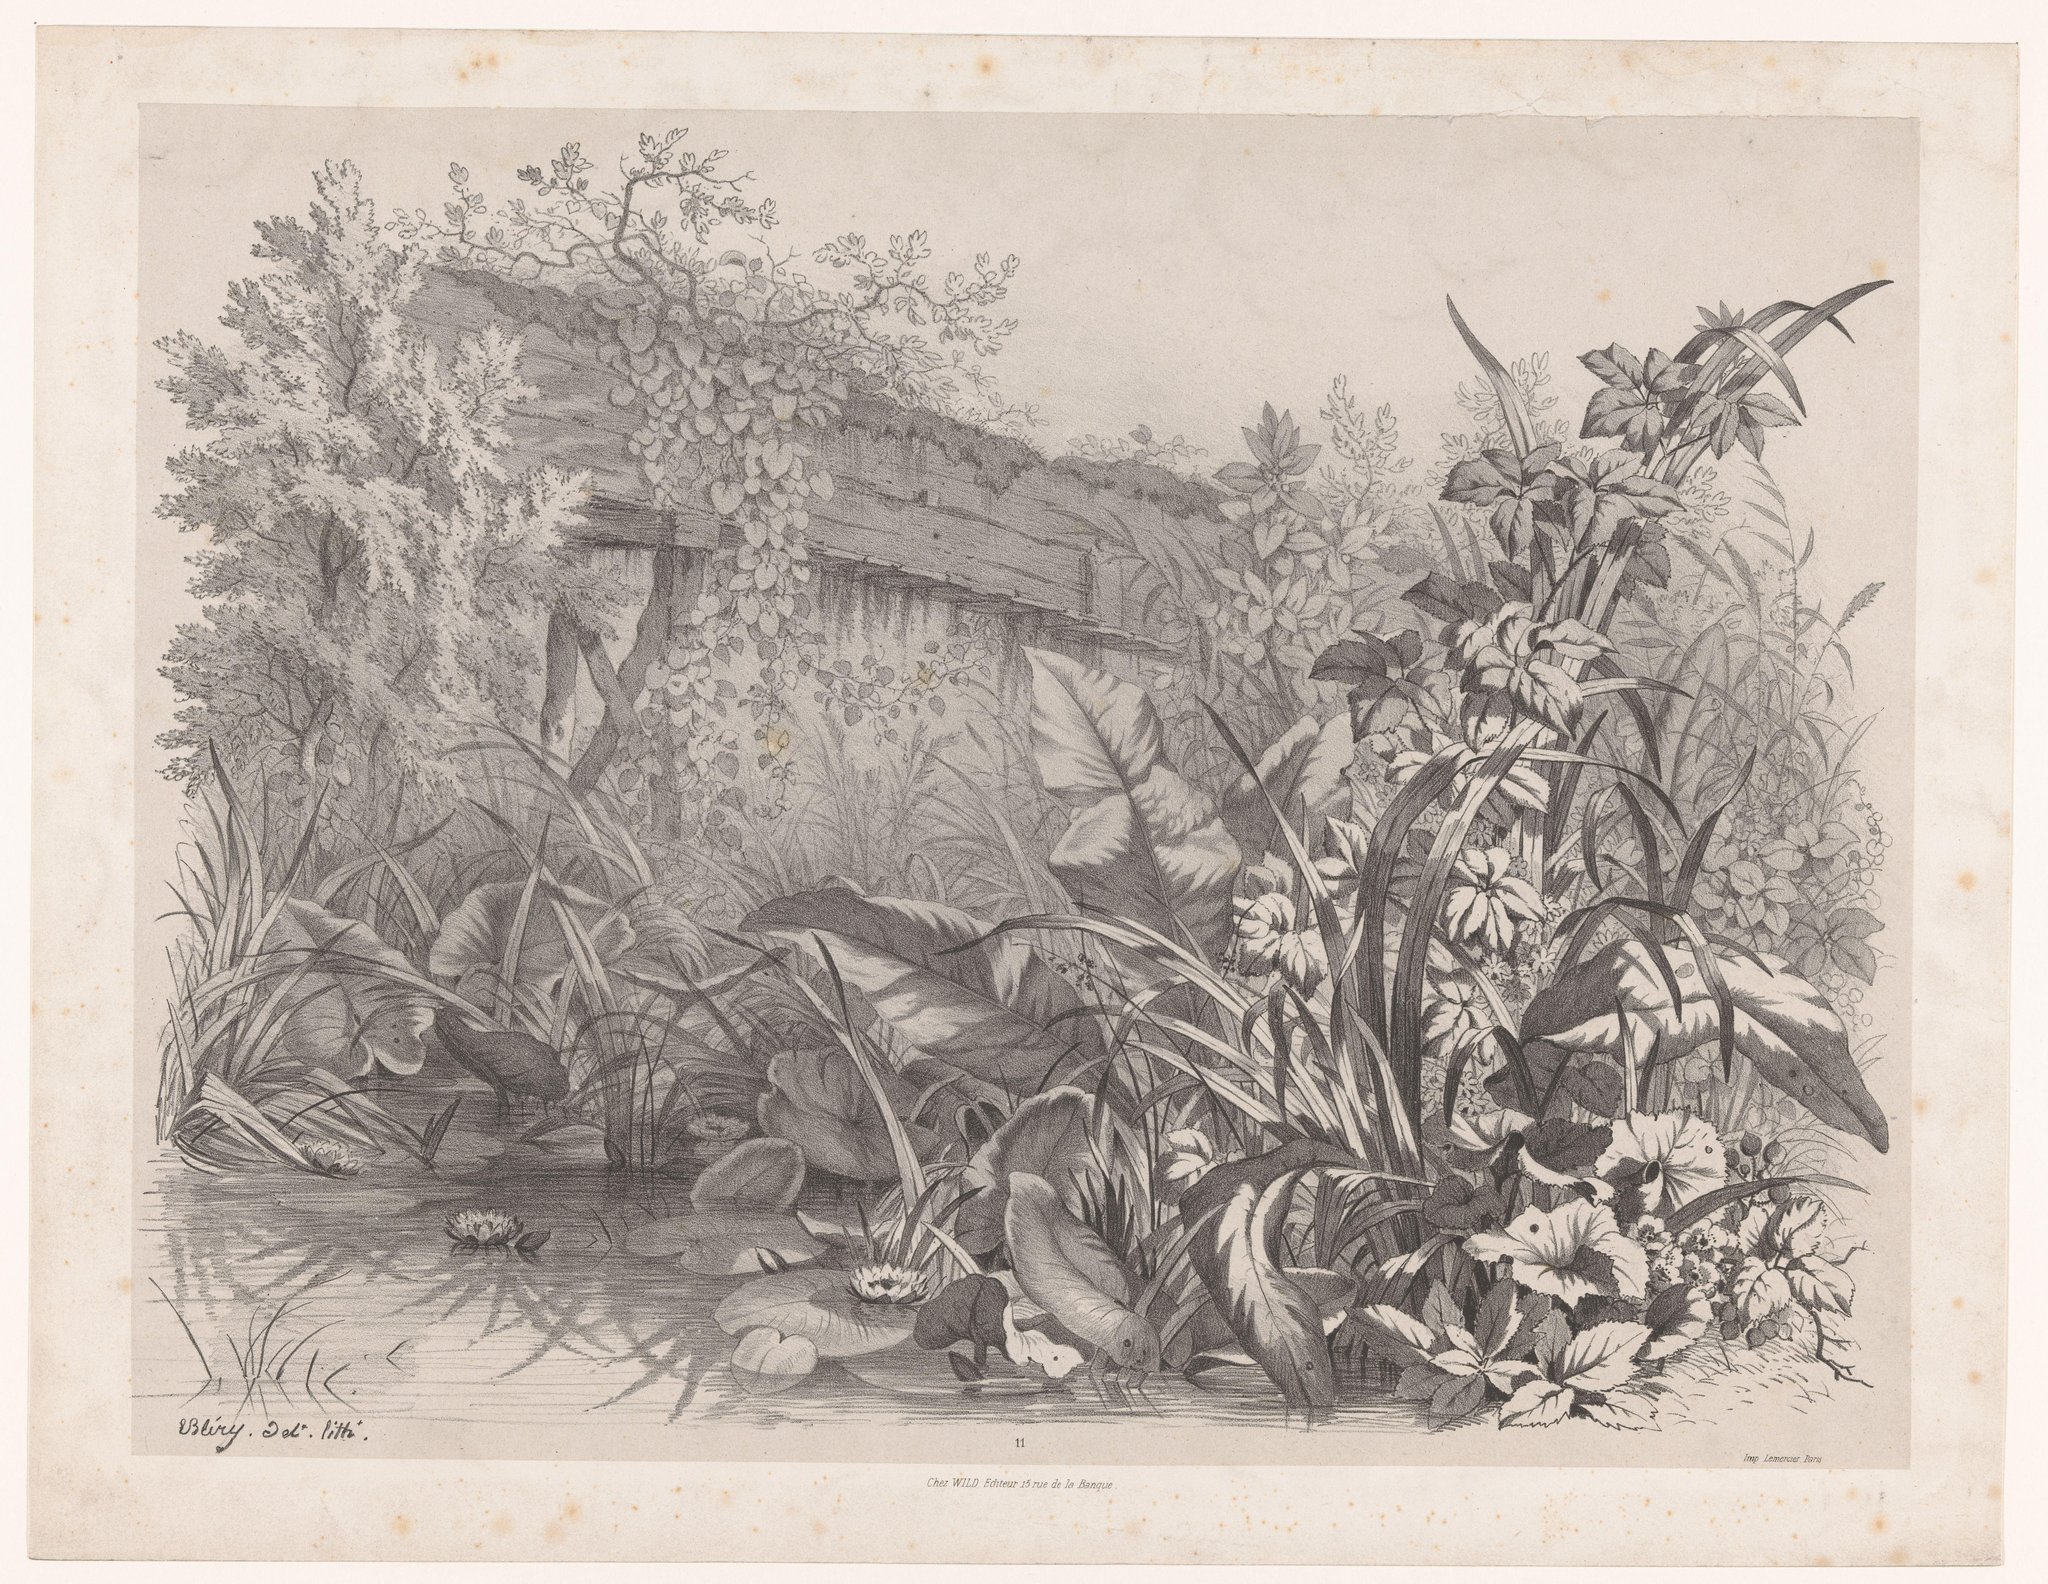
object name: print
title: Planten in het landschap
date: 1856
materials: paper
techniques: lithograph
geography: paris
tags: flowers: water-lily, plants and herbs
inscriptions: collector's mark: Lugt 2760, collector's mark: Lugt 2166